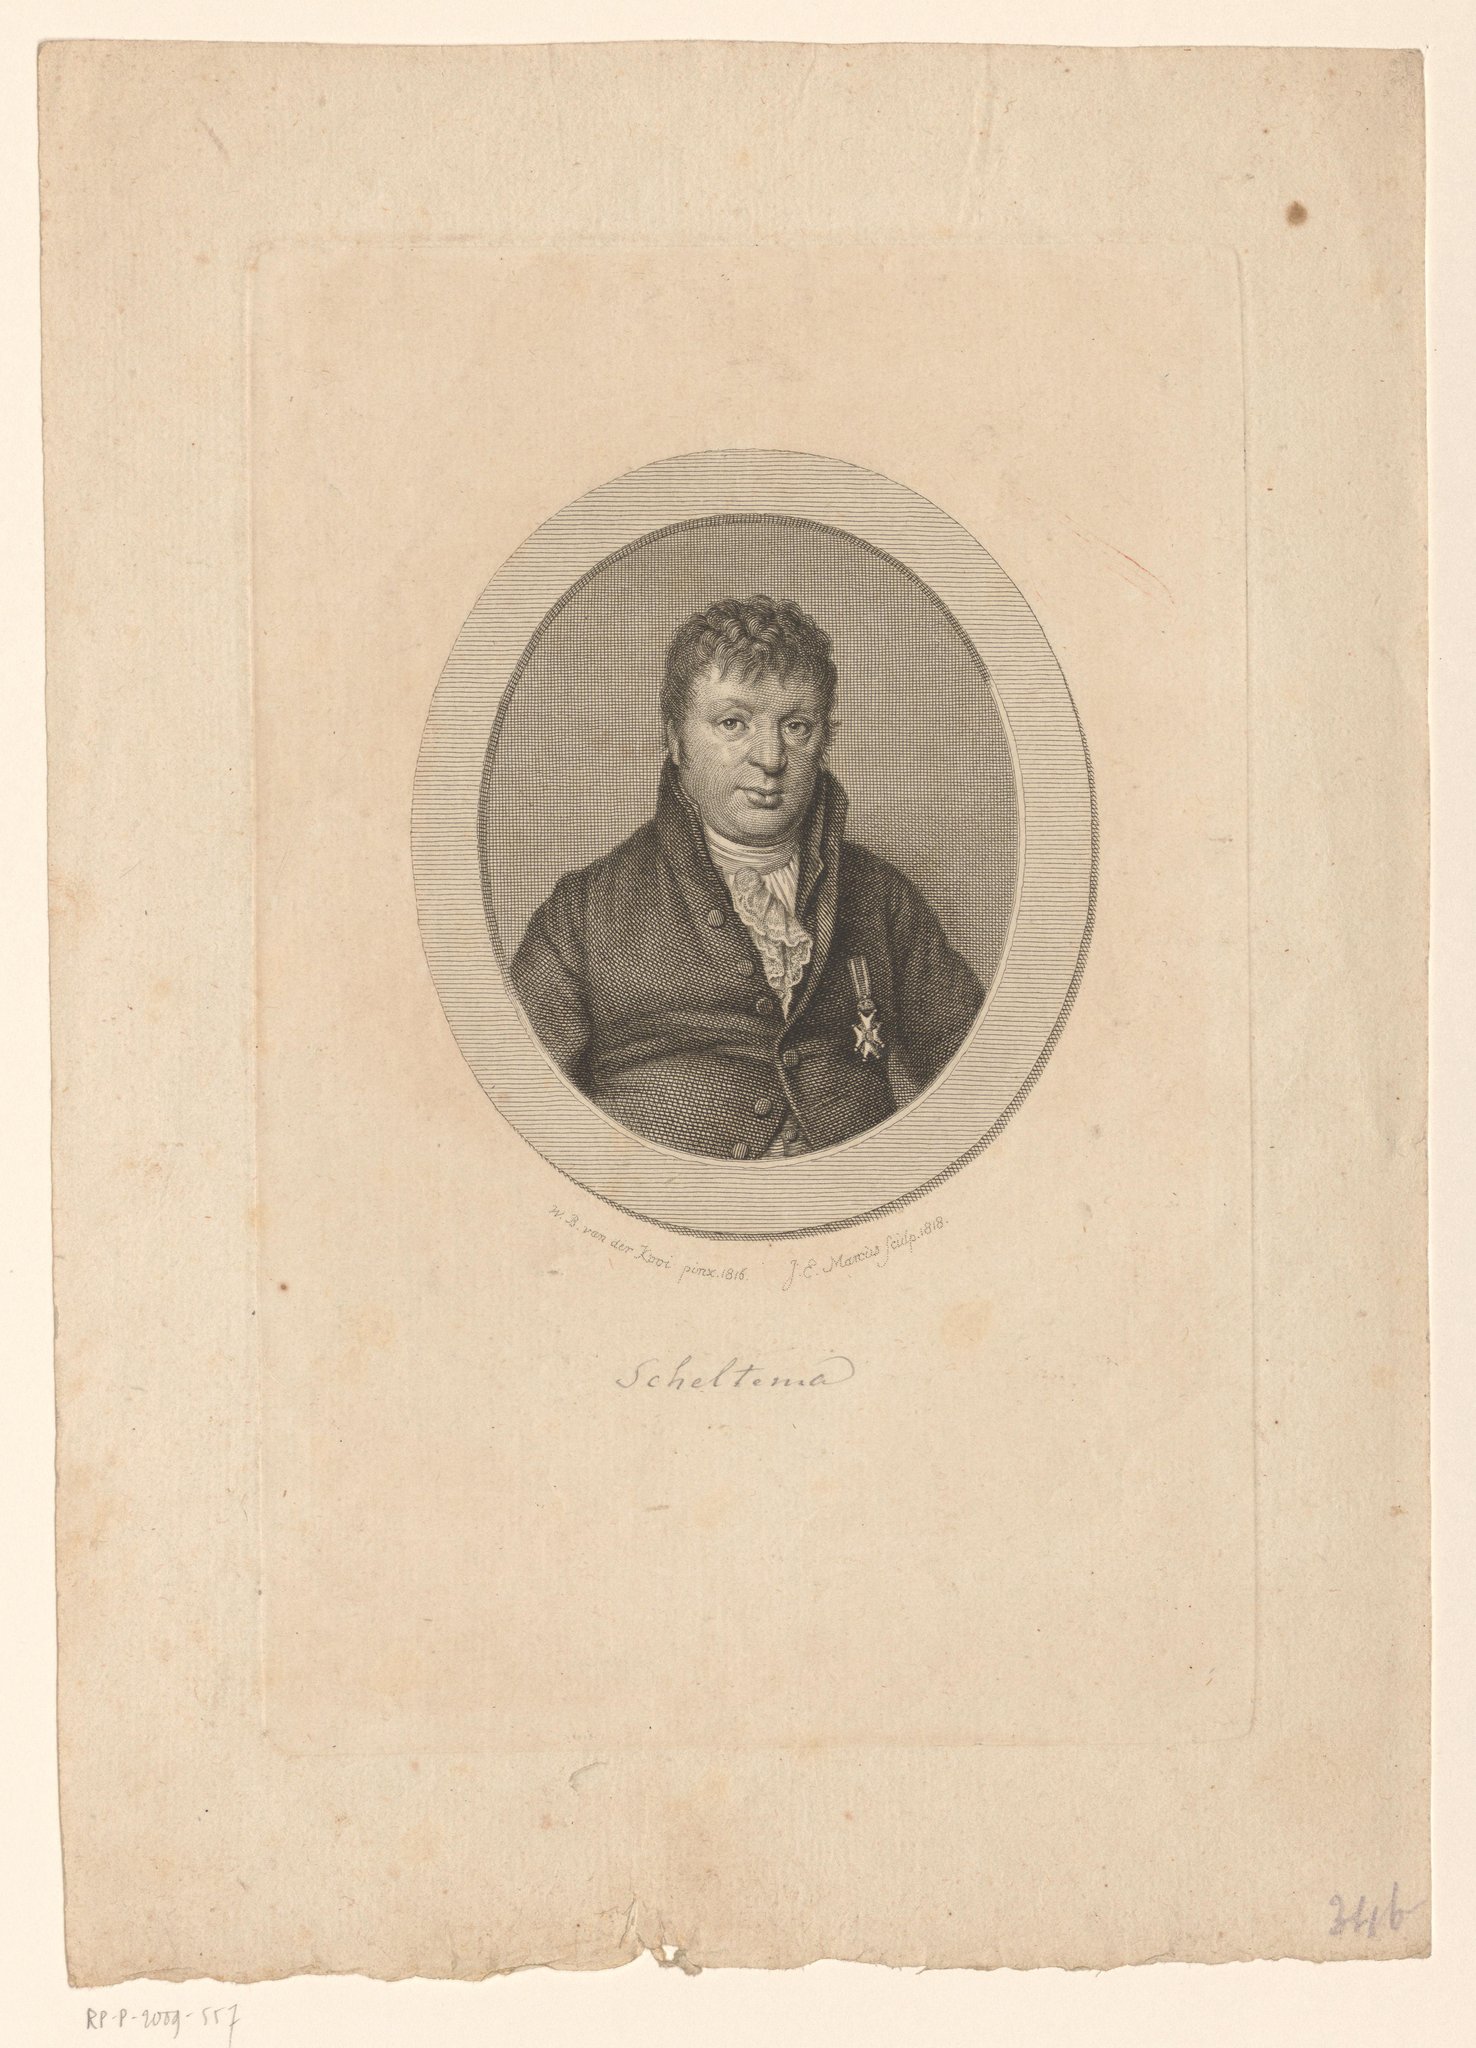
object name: print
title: Portret van Jacobus Scheltema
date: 1818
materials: paper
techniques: engraving, etching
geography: amsterdam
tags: jacobus scheltema, historical persons, portrait of a writer, politician, e.g. party leader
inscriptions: collector's mark: Lugt 2228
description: Proefdruk van portret van Jacobus Scheltema (1767-1835), geschiedschrijver. Geportretteerde in ovaal in kostuum met onderscheiding naar rechts.